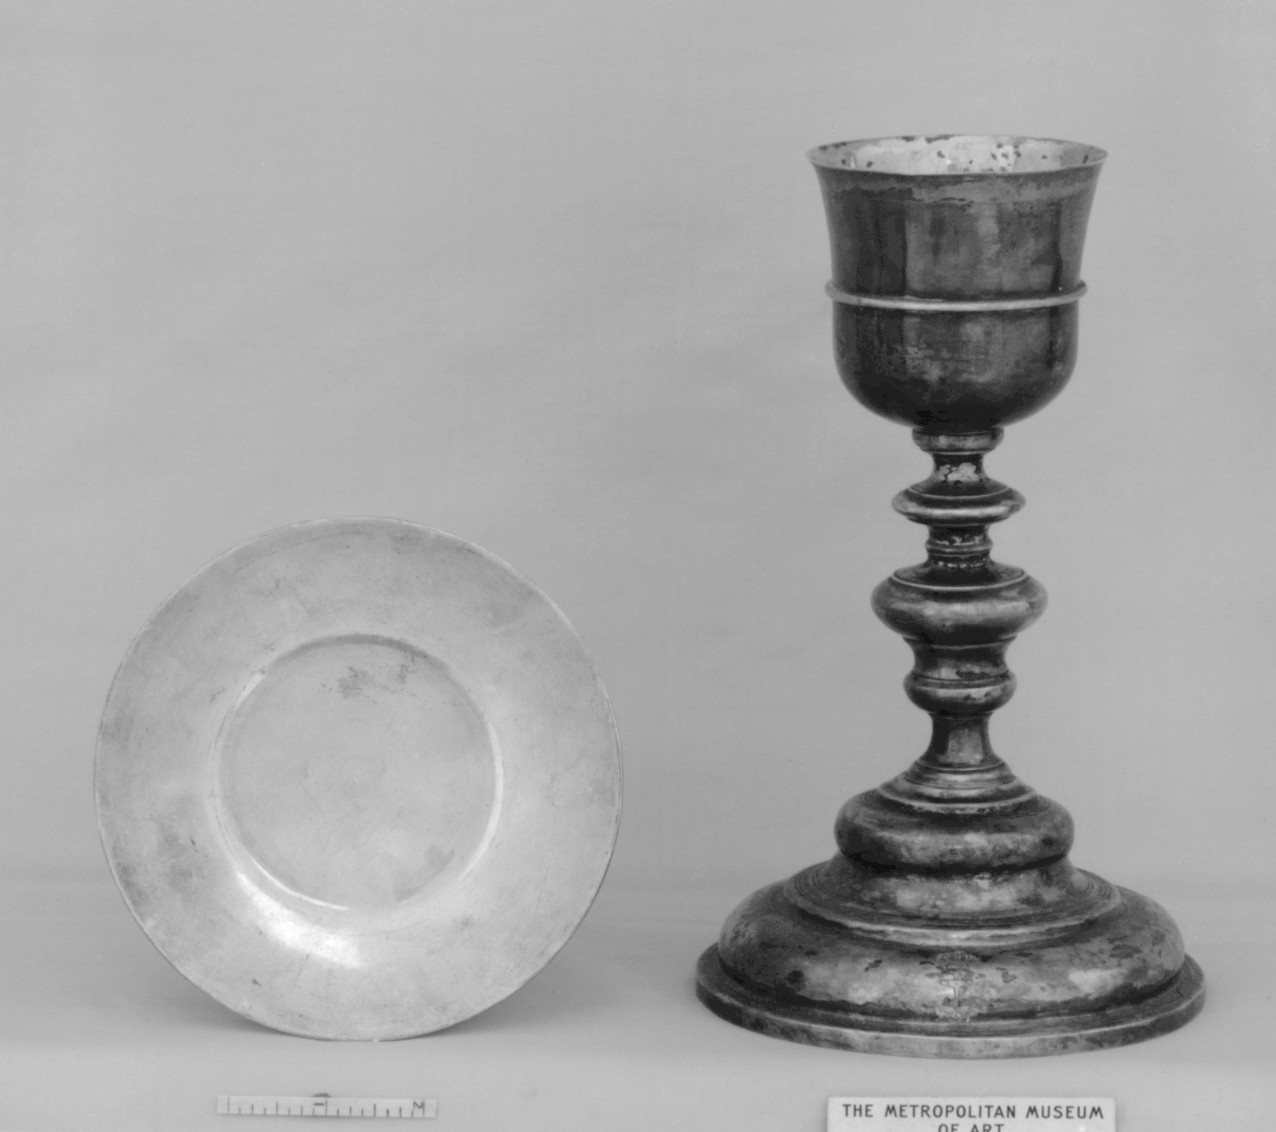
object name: chalice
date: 1701-1800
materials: gilt, silver